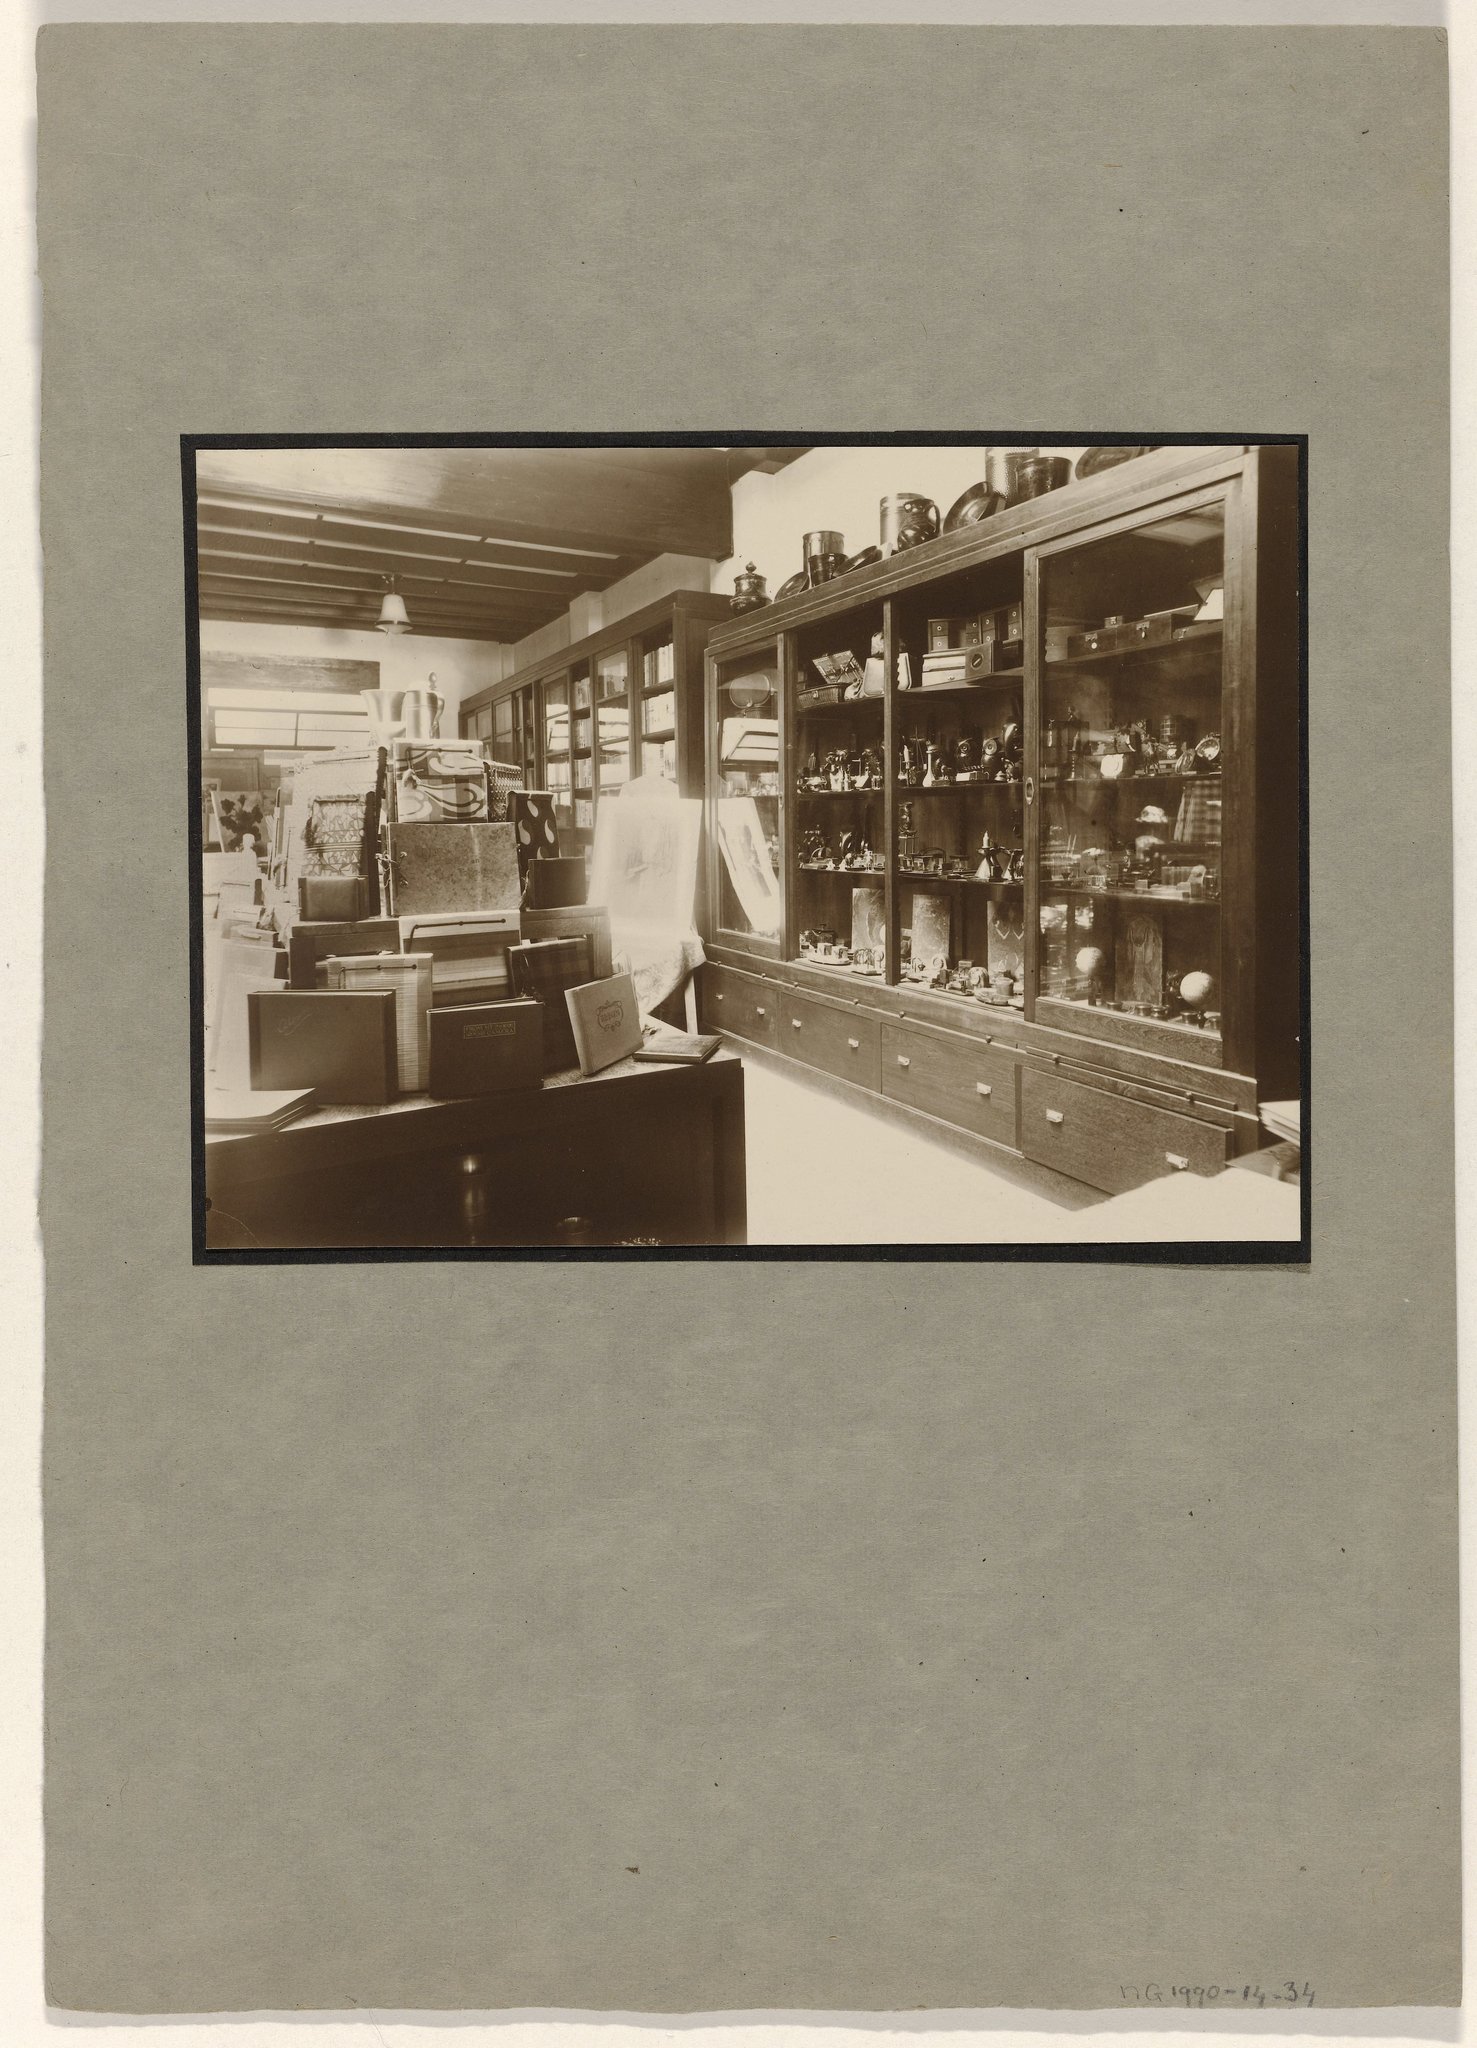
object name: photograph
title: Kast in de winkel van de Deli Courant te Medan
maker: walter t. uhlenhuth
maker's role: fotograaf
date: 1925-1940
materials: cardboard, photographic support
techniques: collodion silver print, gelatin silver print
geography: medan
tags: dutch east indies, the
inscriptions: company name: ‘W.T. Uhlenhuth Medan’, inscription: ‘Boekhandel kast met luxe artikelen’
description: Gezicht in het interieur van de winkel van de drukkerij en boekhandel van de Deli Courant te Medan, met een uitstalling van albums en een wandkast met luxeartikelen. Onderdeel van een groep 49 losse zwart-wit foto's van verschillend formaat over de uitgeverij en drukkerij van de krant Deli Courant in Medan in de periode 1885-1947.